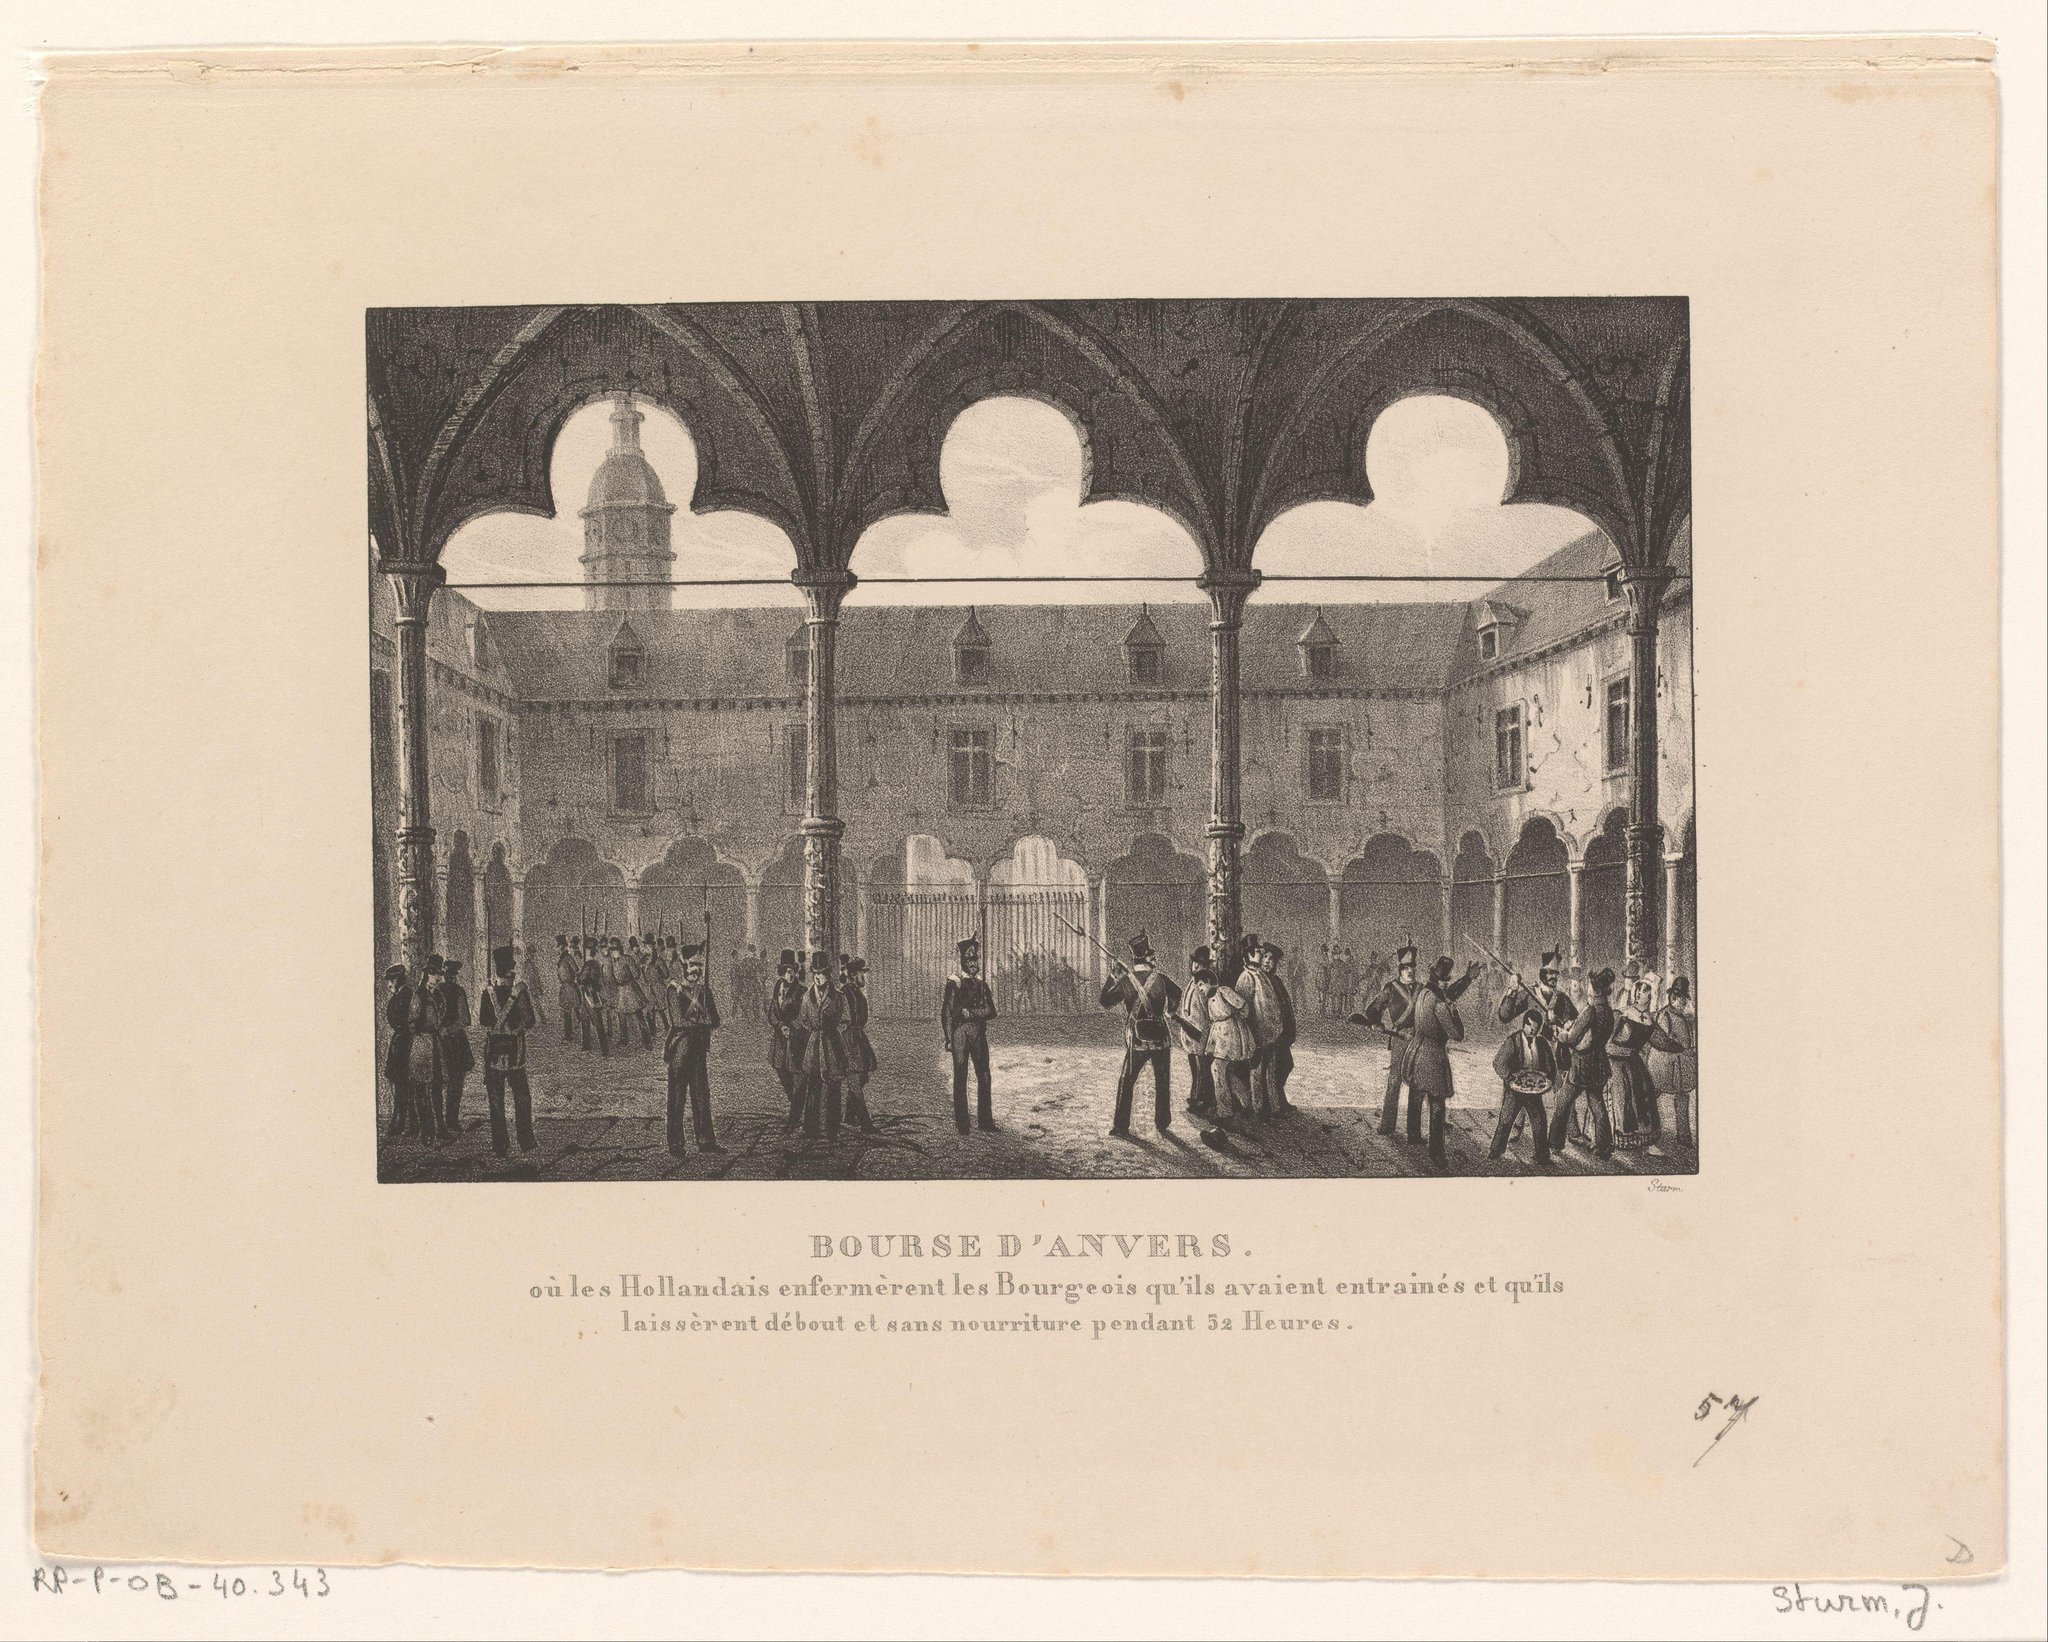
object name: print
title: Bourse d'Anvers. Ou les Hollandais enfermèrent les Bourgeois qu'ils avaient entrainés et qu'ils laissèrent débout et sans nourriture pendant 52 heures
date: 1830-1831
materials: paper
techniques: lithograph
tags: prison, jail, prisoner of war camp, antwerp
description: Onderdeel van een groep prenten uit verschillende andere series verwant aan de platen in het recueil over de gebeurtenissen tijdens de Belgische Revolutie in Brussel, Antwerpen en andere steden in de periode van 25 augustus 1830 tot 27 maart 1831. Uitgegeven in een serie van 23 prenten getiteld: Evénemens de la Belgique Dessinés sur les lieux par des témoins oculaires. Brussel: Jean Baptiste Jobard, [1831].